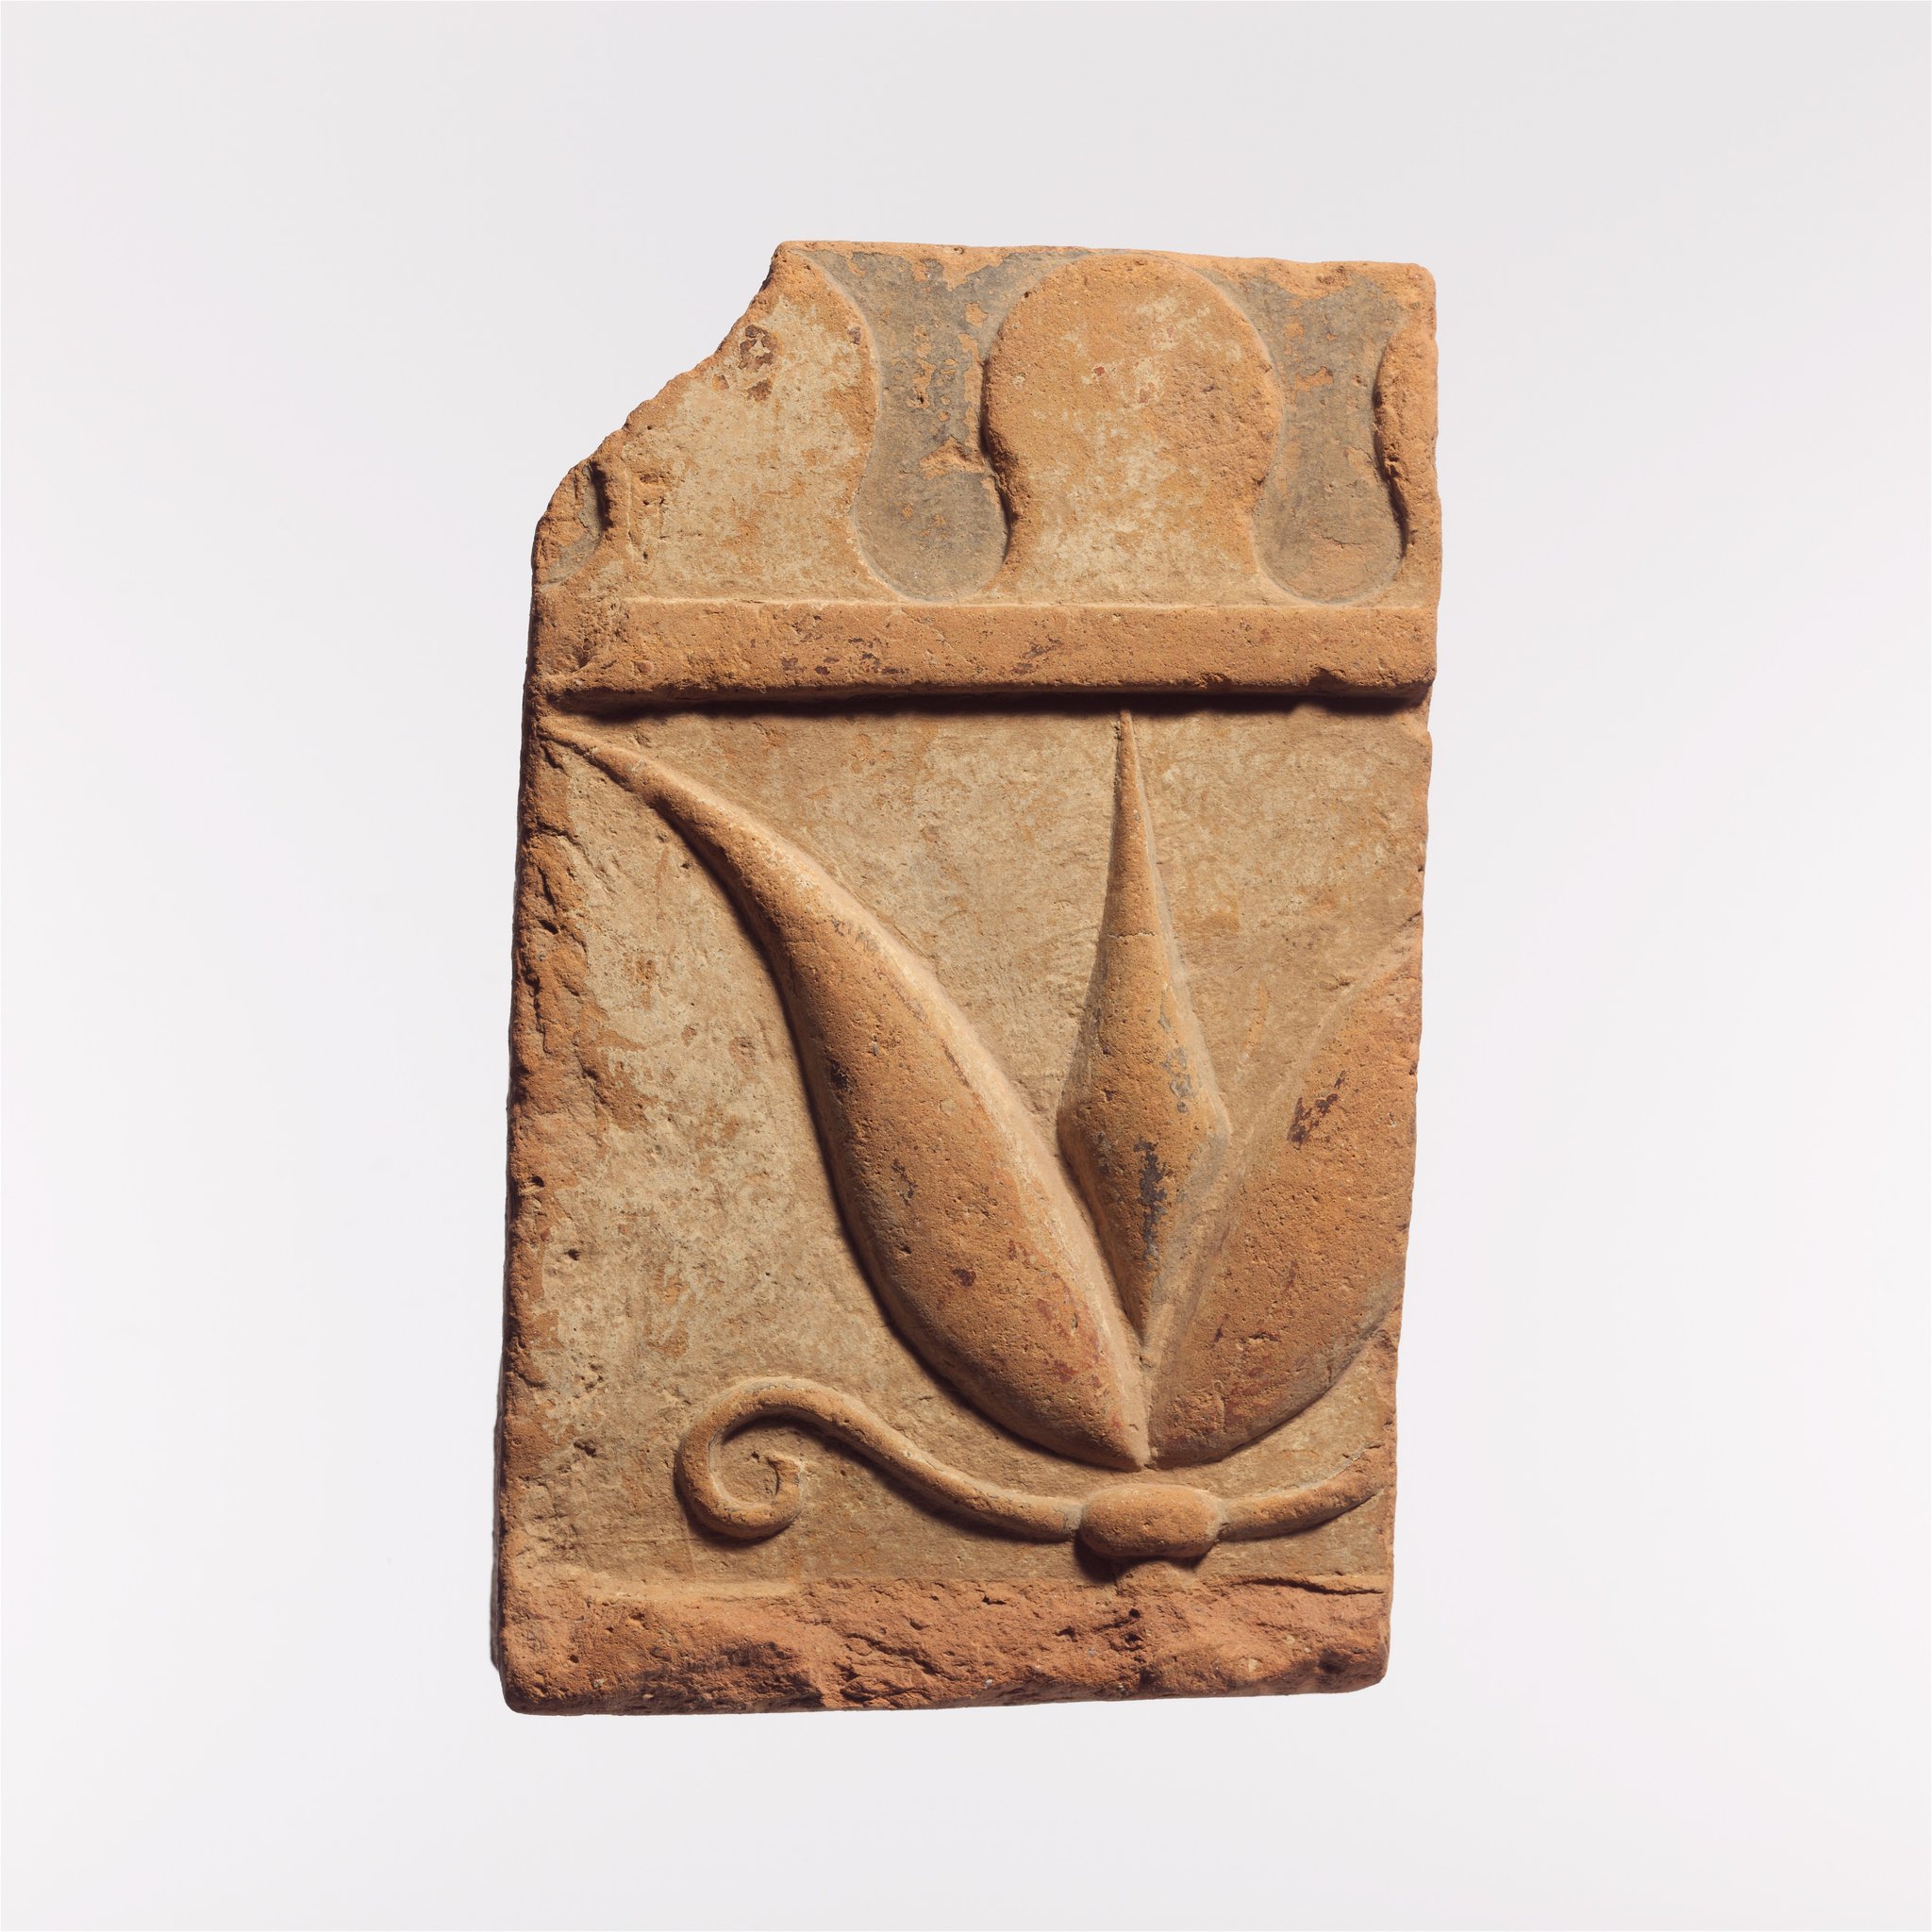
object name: tile fragment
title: Fragment of a terracotta architectural tile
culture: lydian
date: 600-501 BCE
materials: terracotta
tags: lotuses